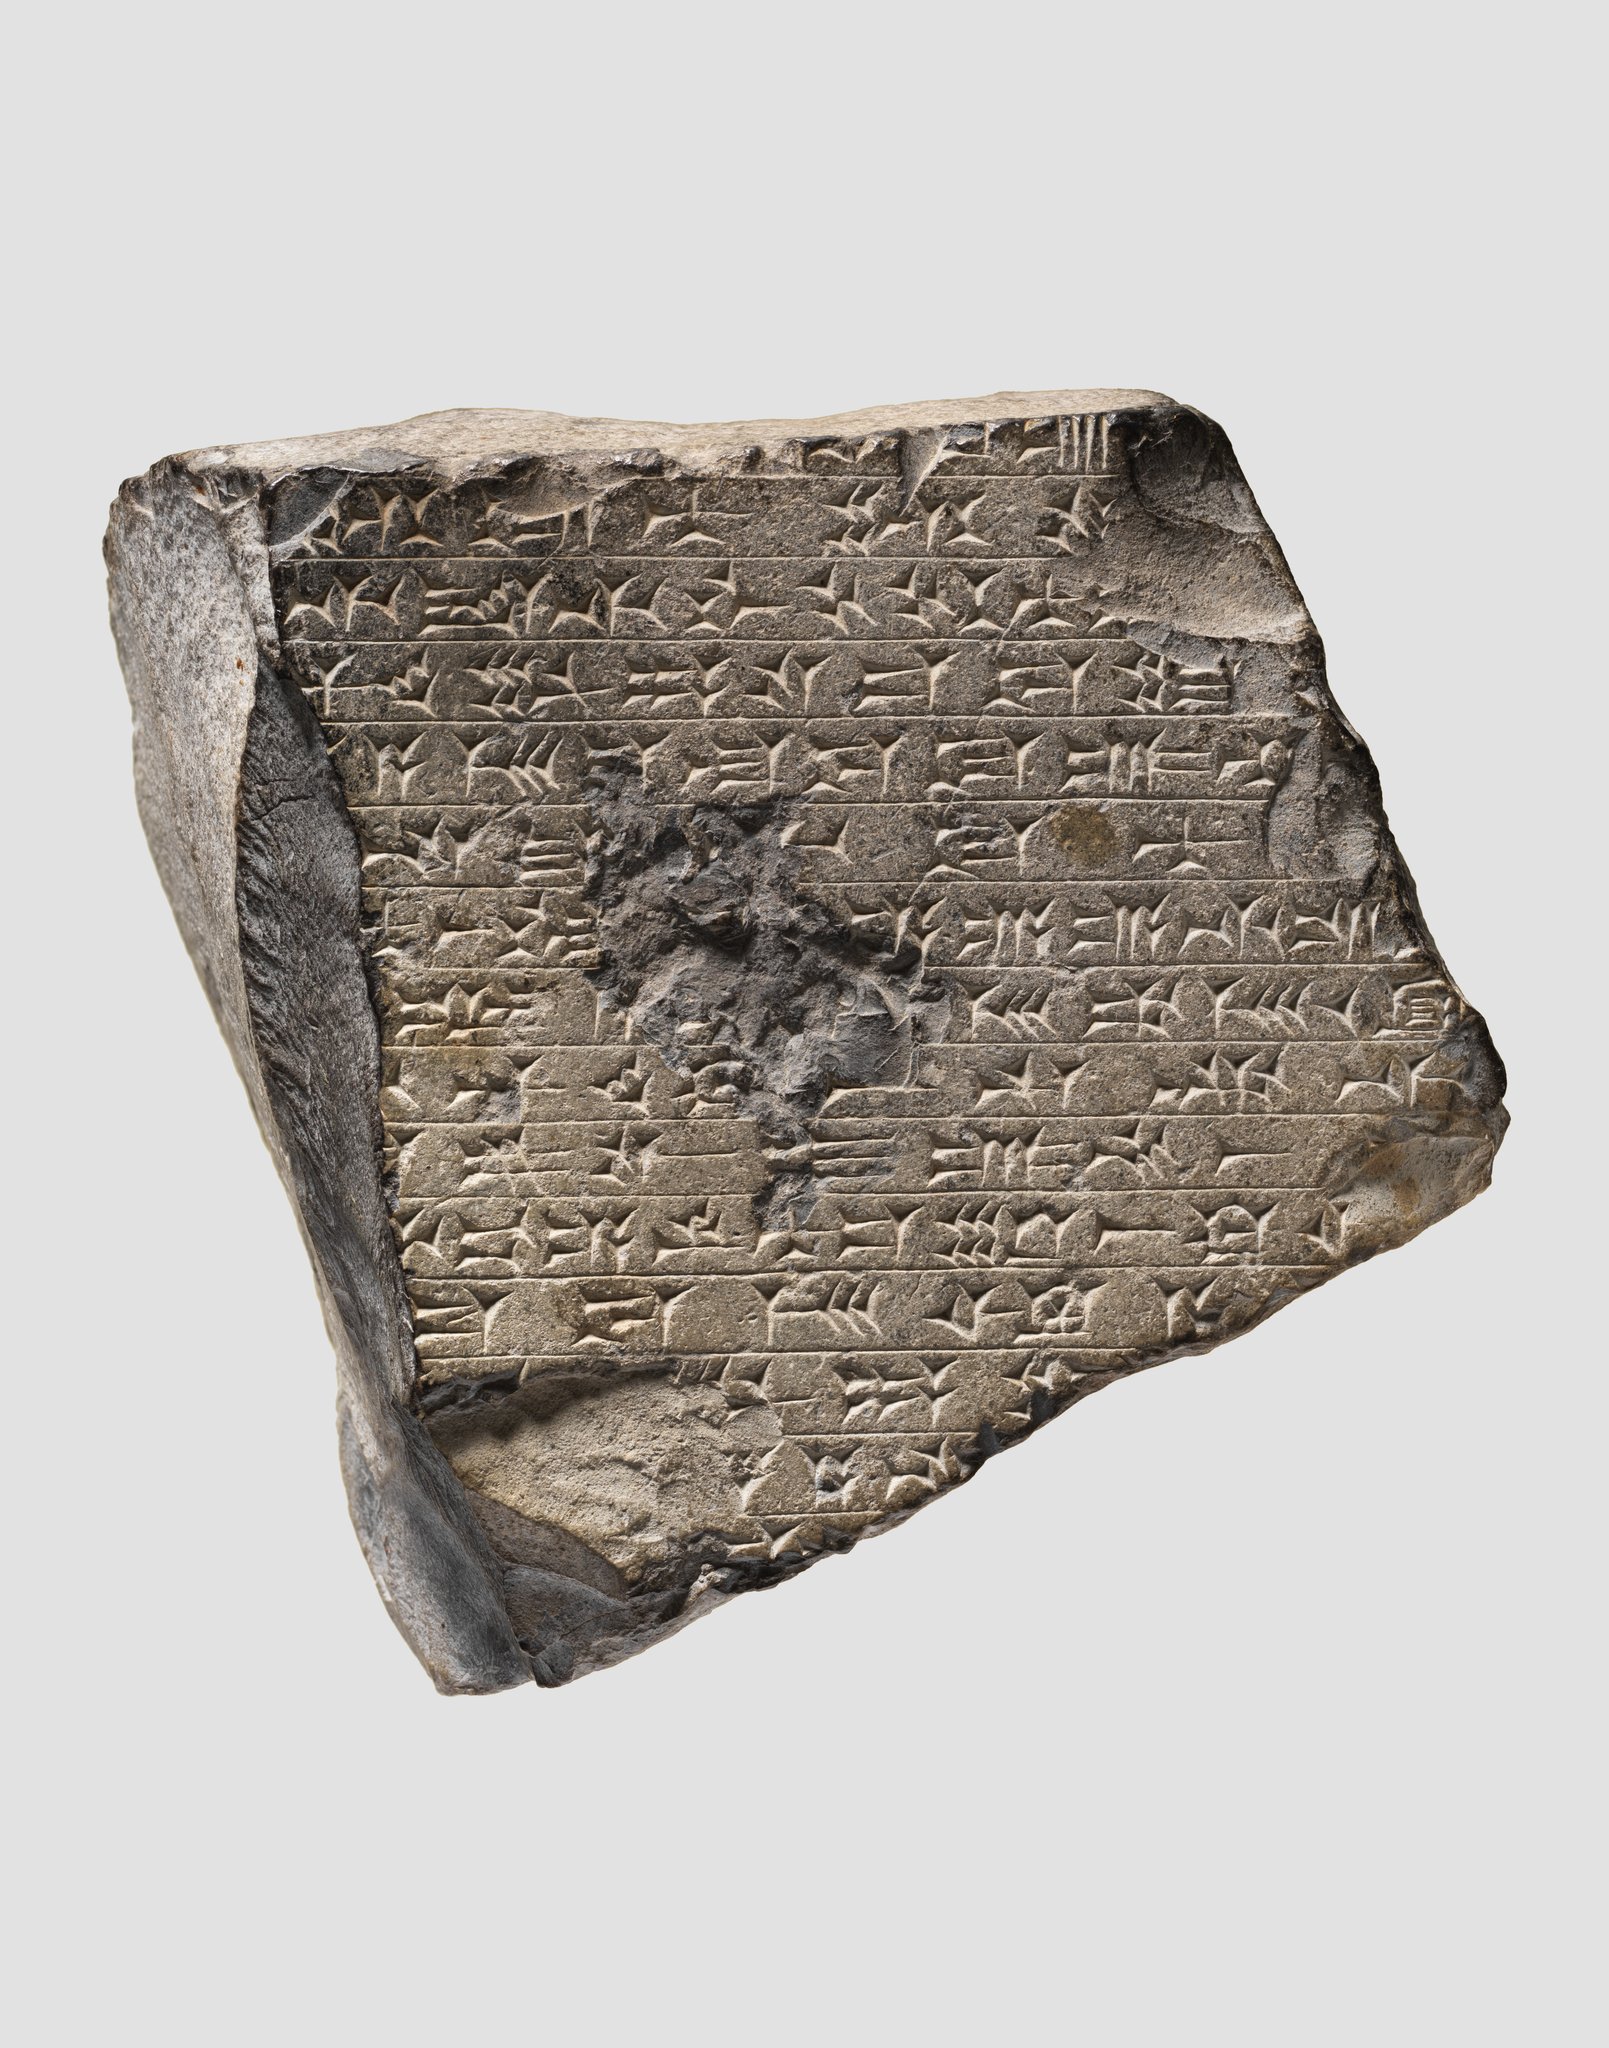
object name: slab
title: Stone slab fragment with inscription from annals of Ashurbanipal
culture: assyrian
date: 668-627 BCE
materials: limestone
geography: mesopotamia